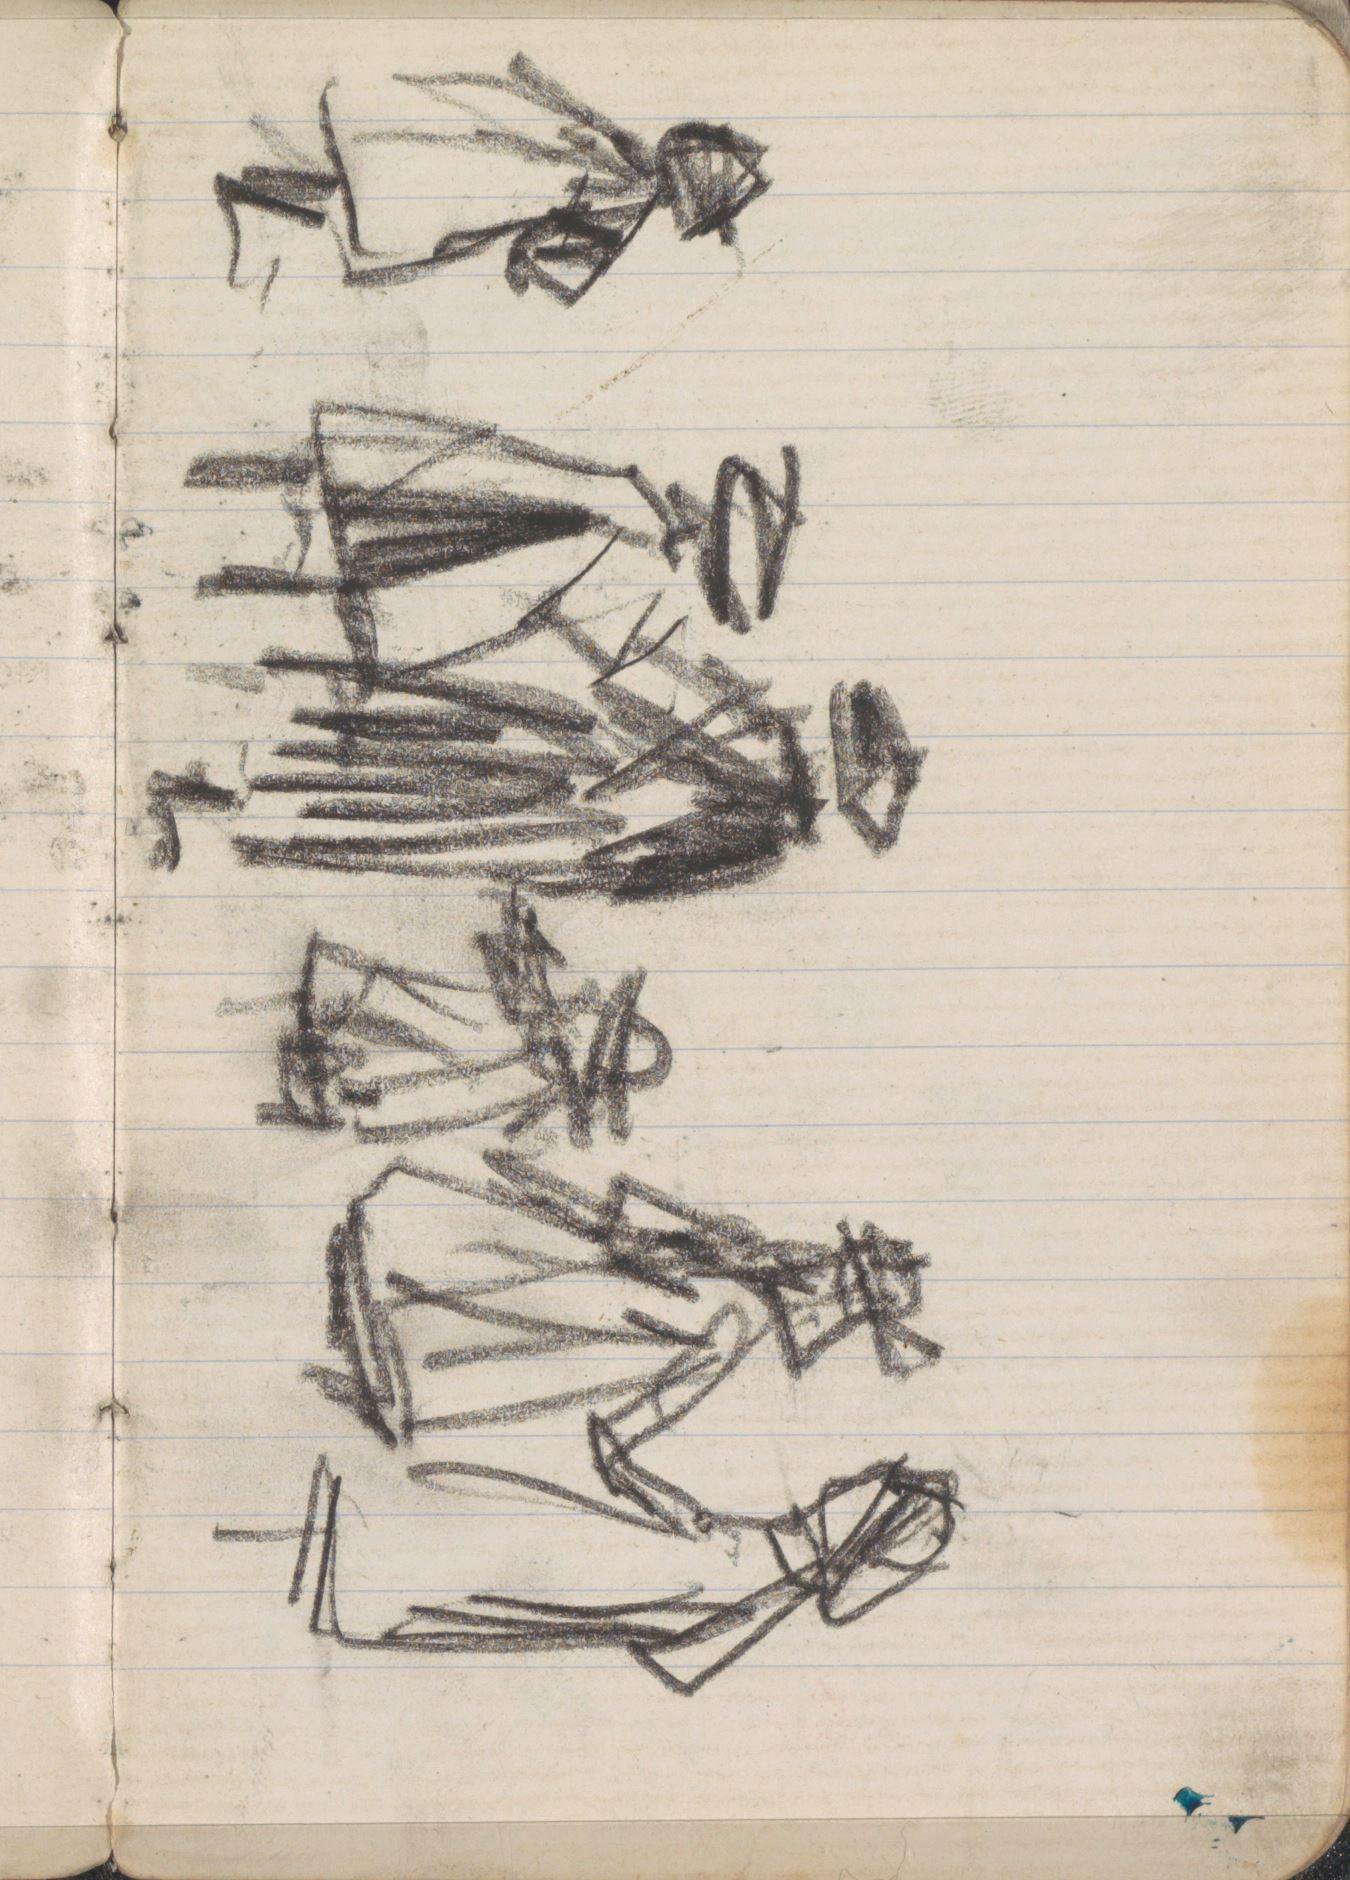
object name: sketchbook leaf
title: Meisjes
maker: george hendrik breitner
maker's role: draughtsman, painter, print maker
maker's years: 1857-1923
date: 1896-1901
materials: chalk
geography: amsterdam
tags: girl (child between toddler and youth)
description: Pagina 10 uit een schetsboek met 37 bladen.